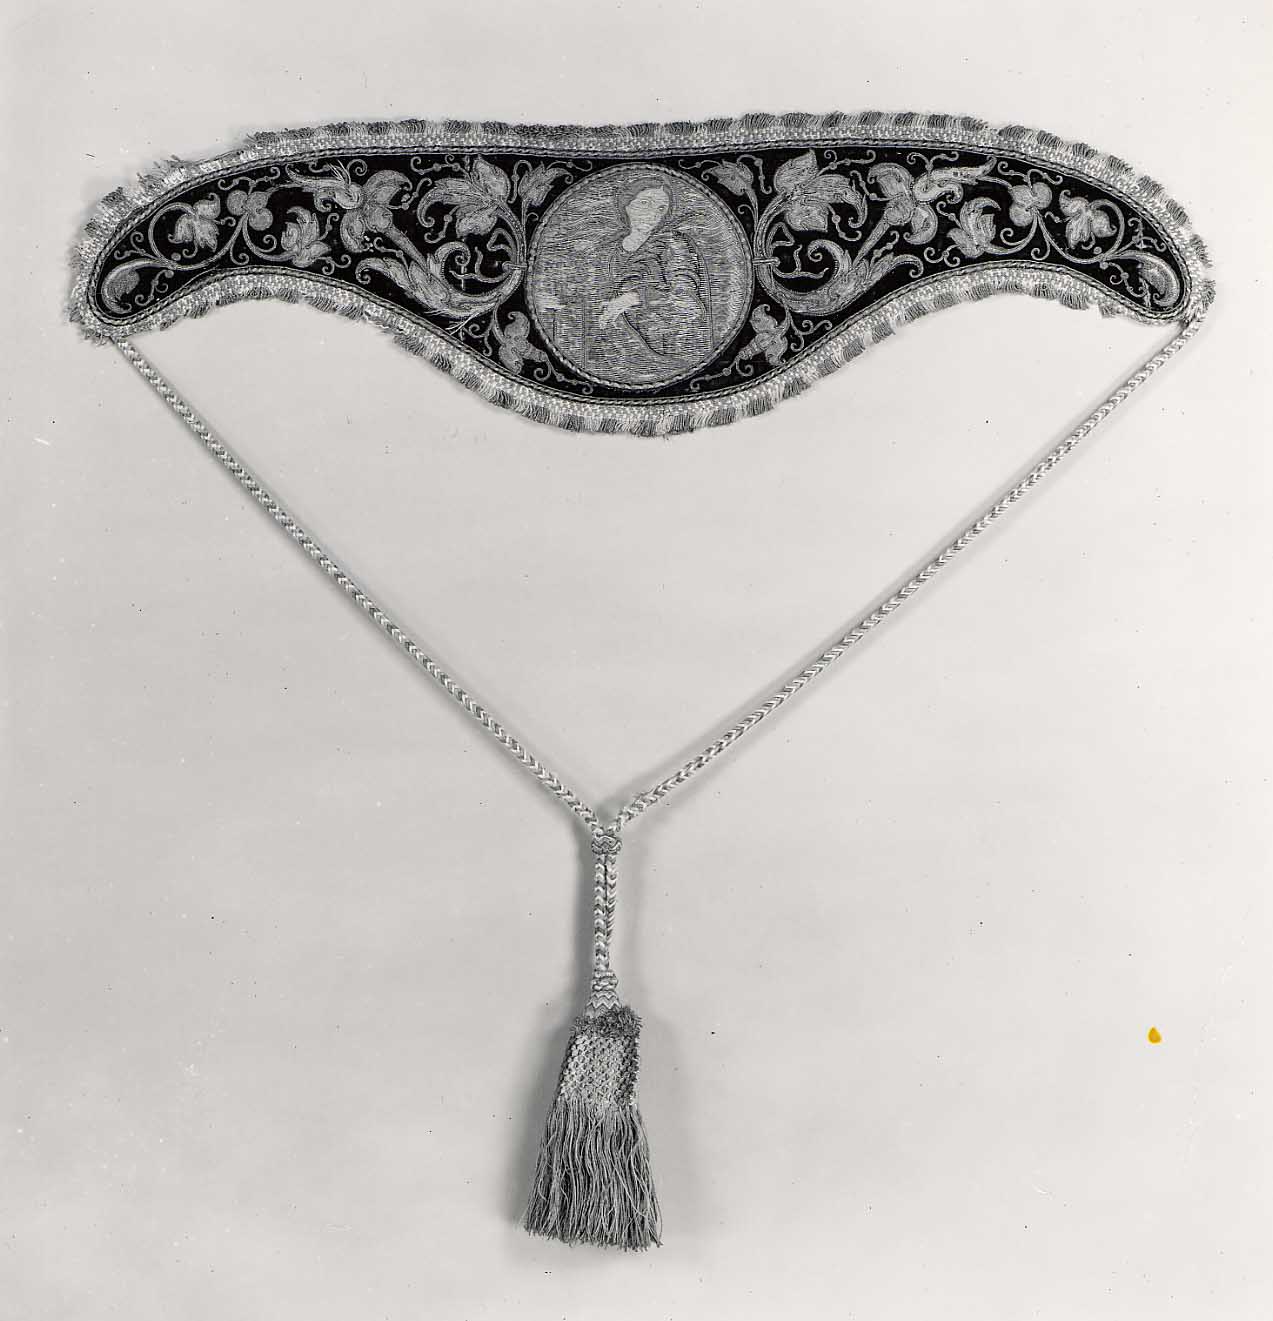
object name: amice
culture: spanish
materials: linen, metal, silk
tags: women